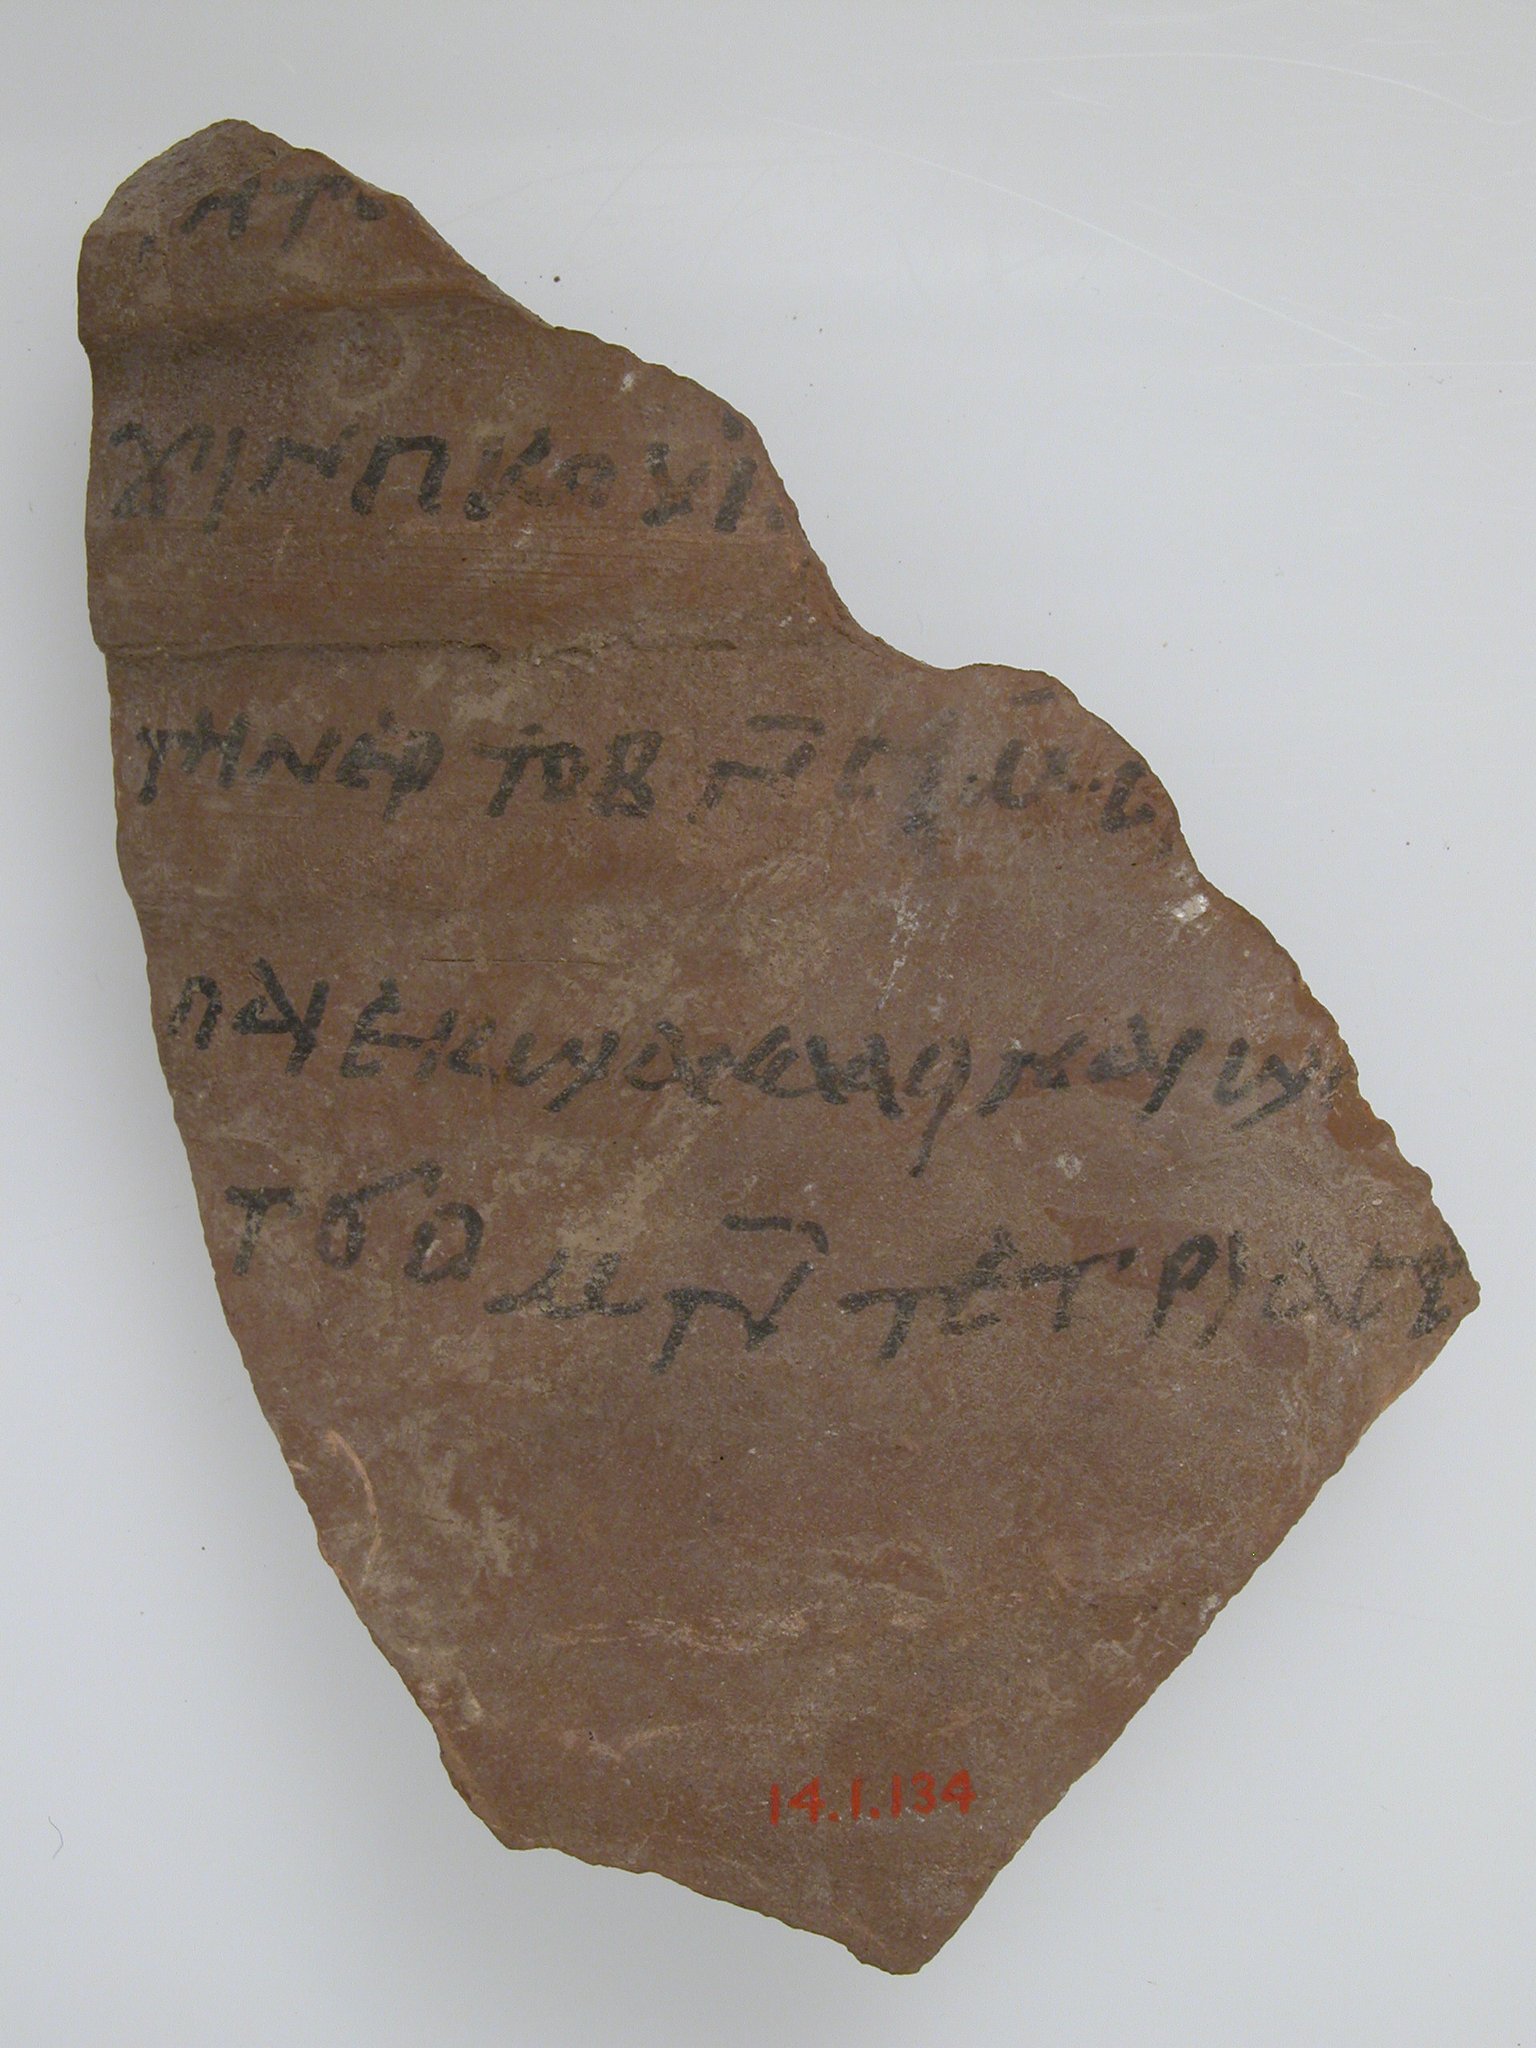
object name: ostrakon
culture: coptic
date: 600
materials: ink, pottery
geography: egypt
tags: coptic,documents